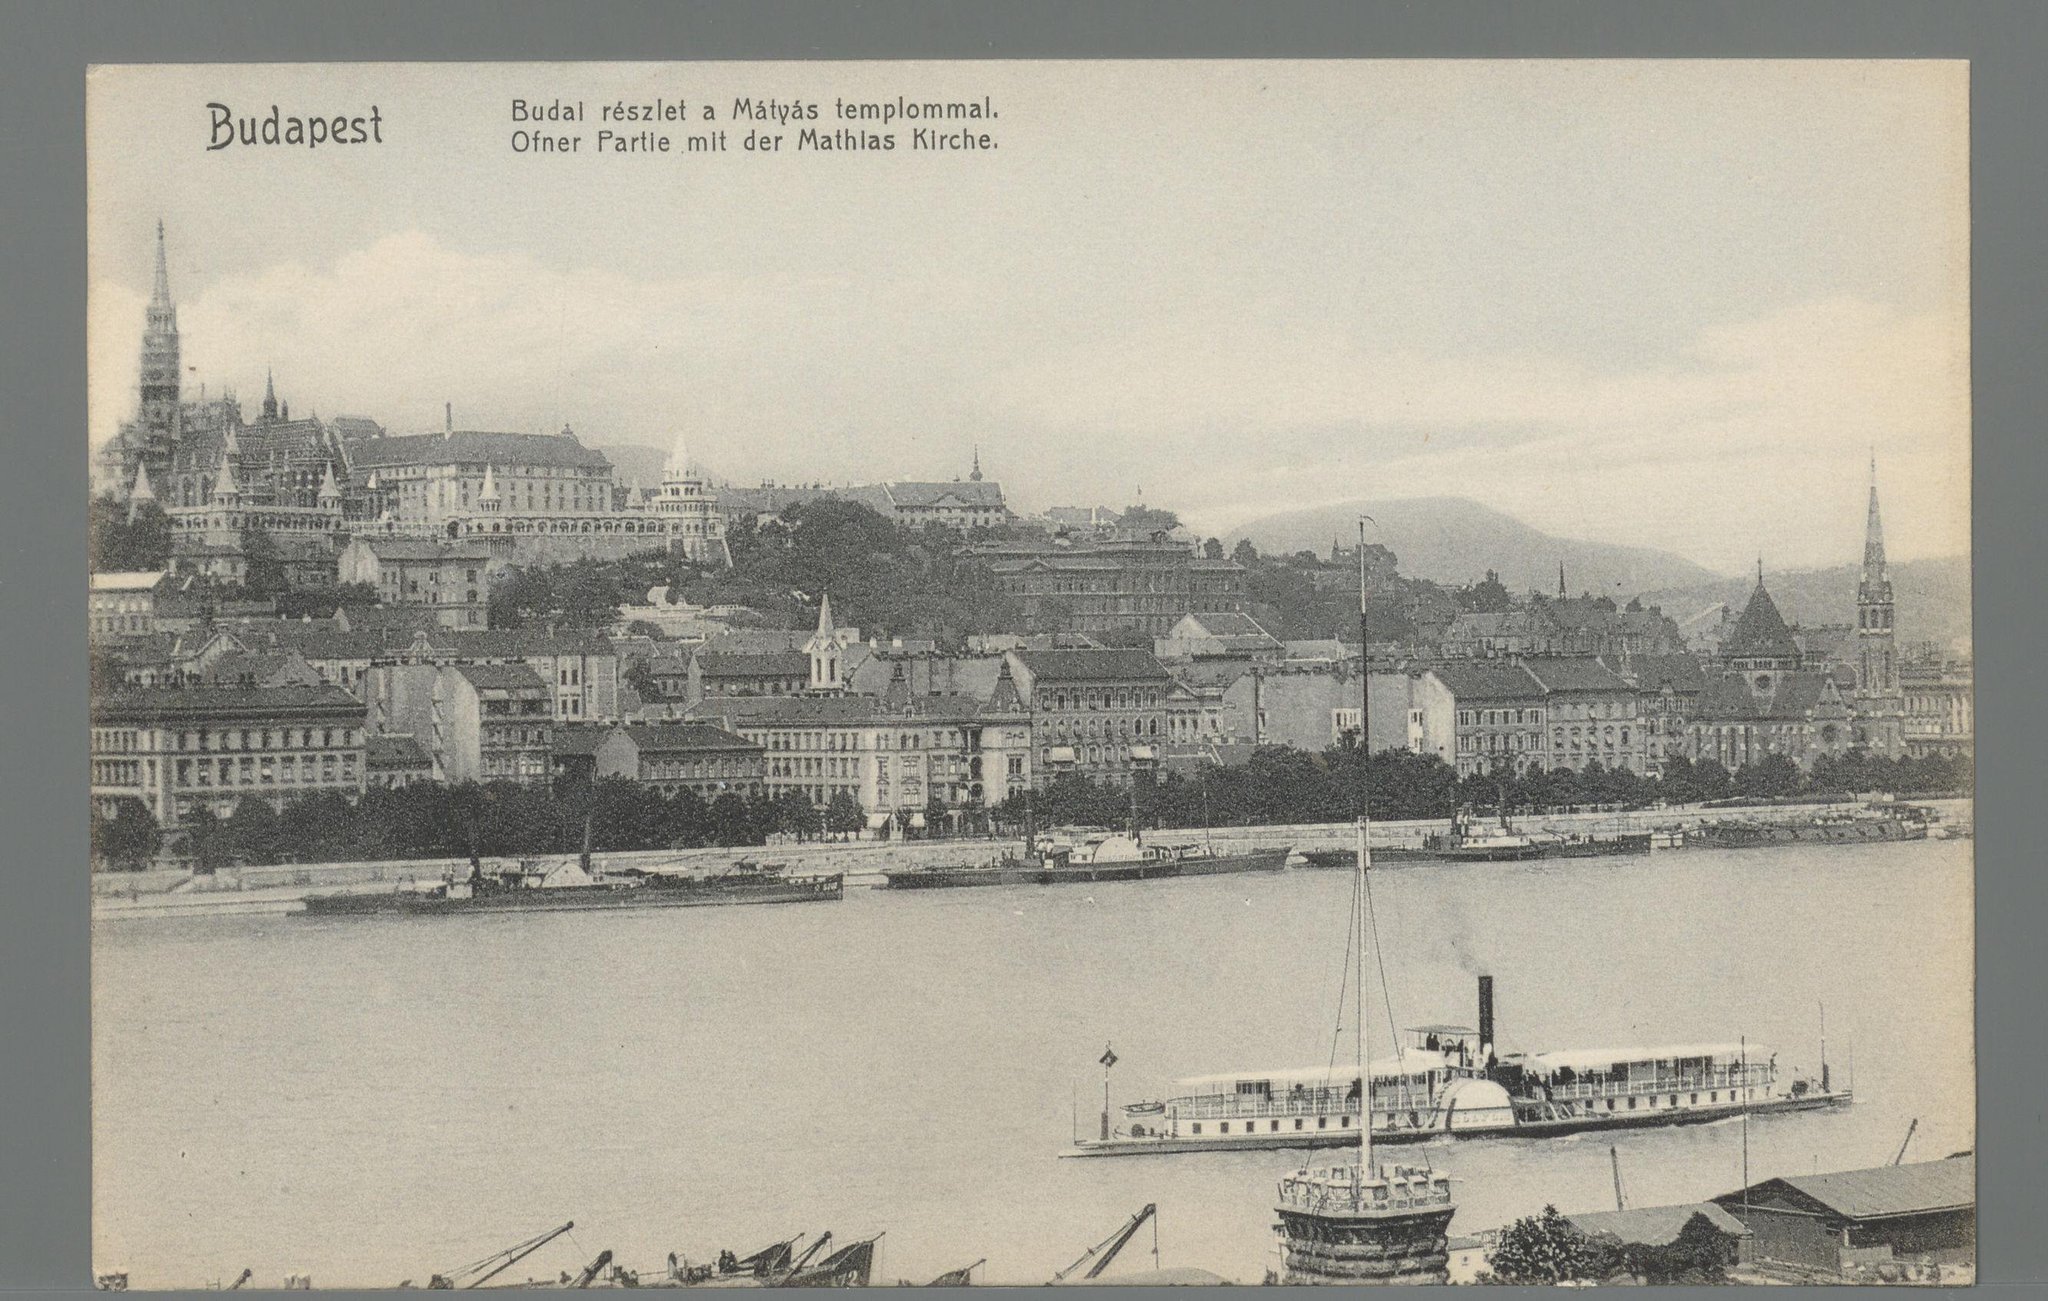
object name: ansichtkaart, prentbriefkaart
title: Budapest. Budal részlet a Mátyás templommal / Ofner Partie mit der Mathias Kirche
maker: Anonymous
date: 1905-1930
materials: cardboard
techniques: photograph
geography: budapest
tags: city-view, and landscape with man-made constructions, church (exterior), canals, waters (in city), steamship, motorship